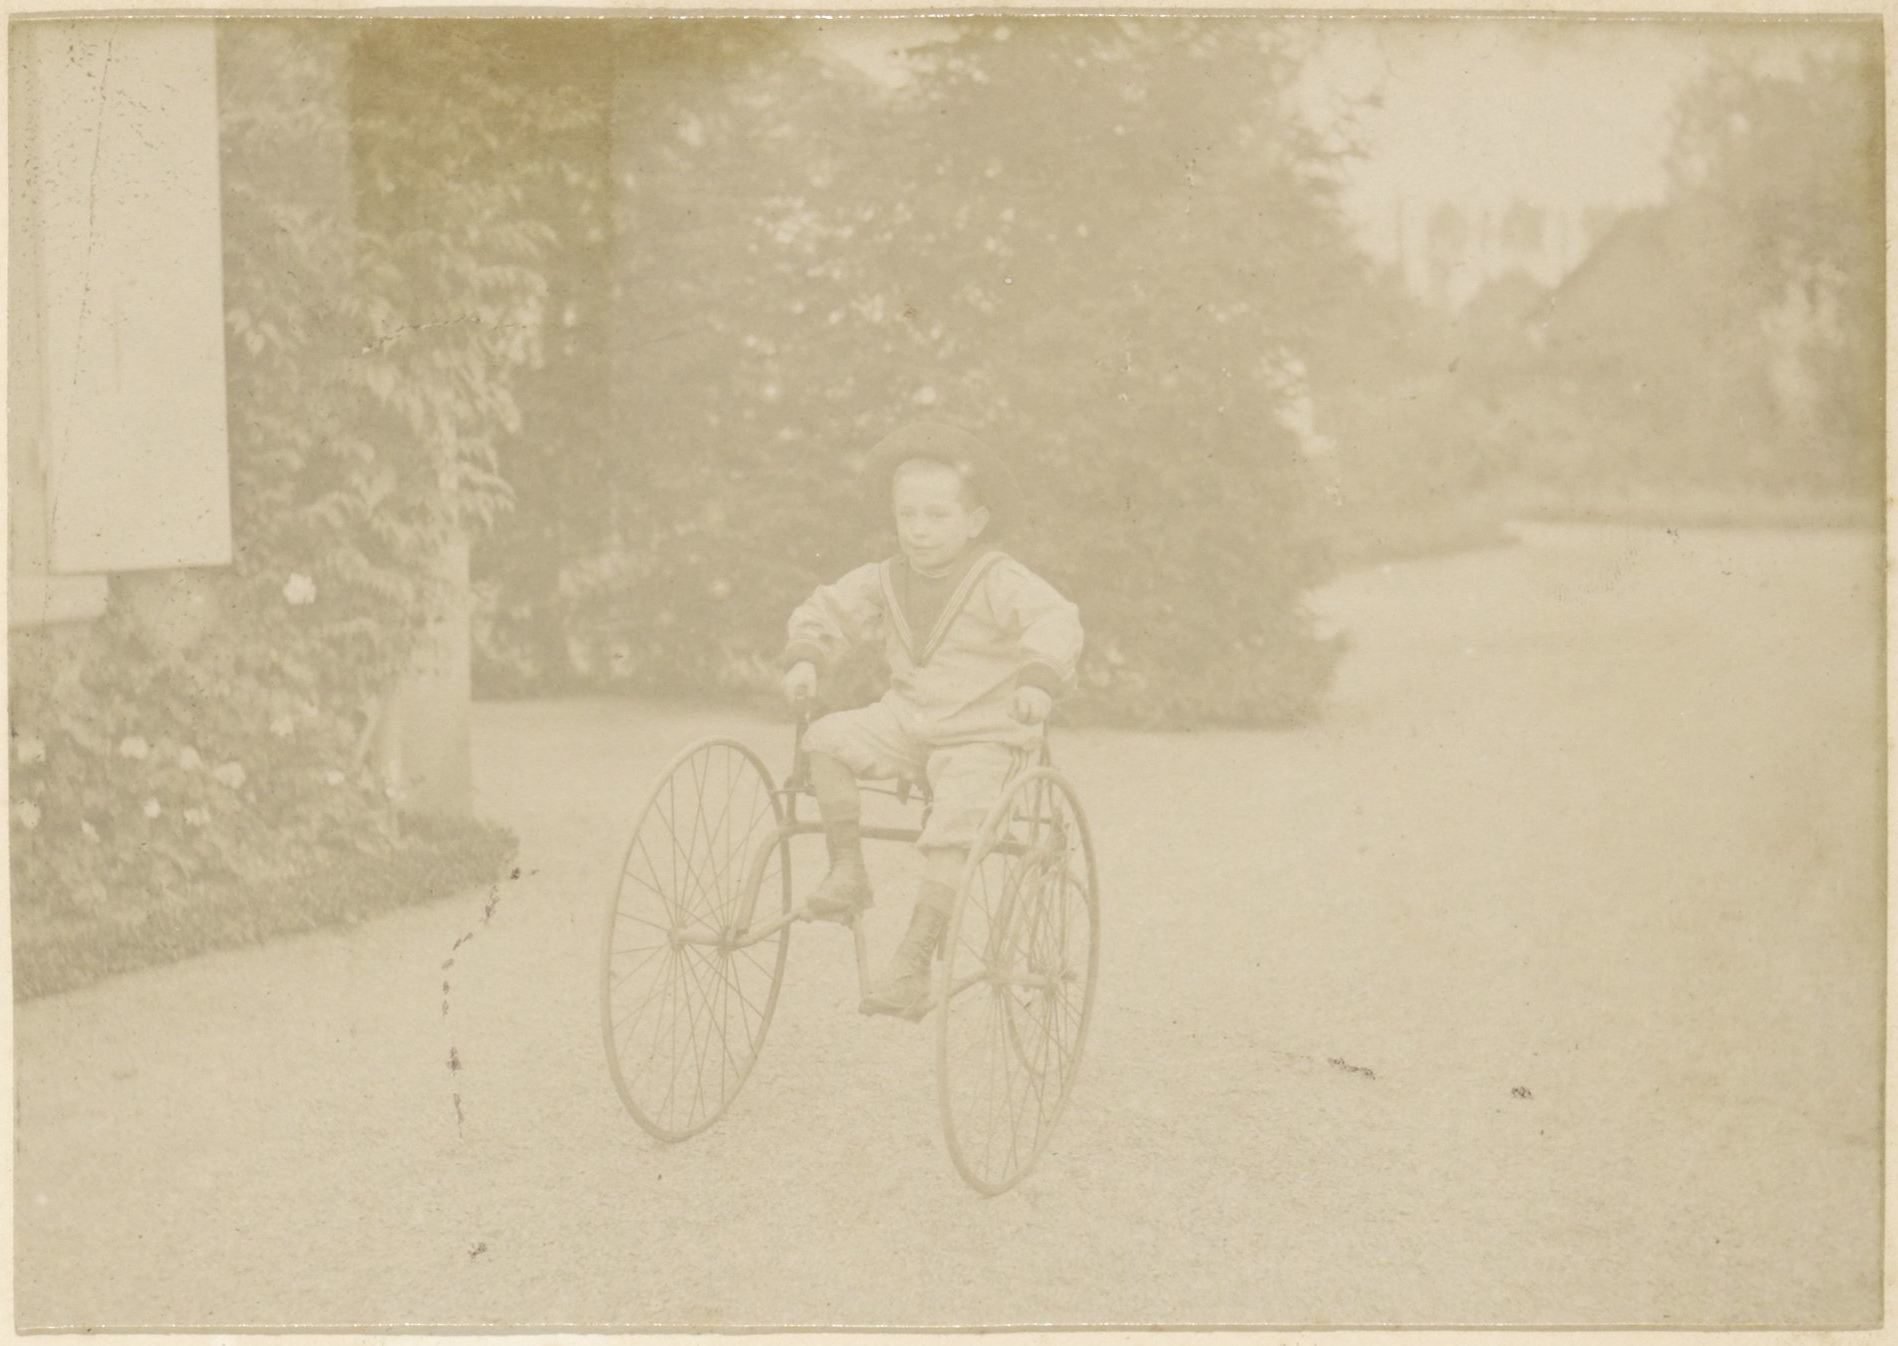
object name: photograph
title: Jongen rijdend op een driewieler in een tuin in Frankrijk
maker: Anonymous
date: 1900-1910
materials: paper, photographic support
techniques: albumen print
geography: france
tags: riding, cycling (recreation), tricycle, child, france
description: Onderdeel van Fotoalbum van een Franse amateurfotograaf met opnames van een familie, distilleerderij Delizy & Doistau Fils, het leger en bezienswaardigheden in Frankrijk.